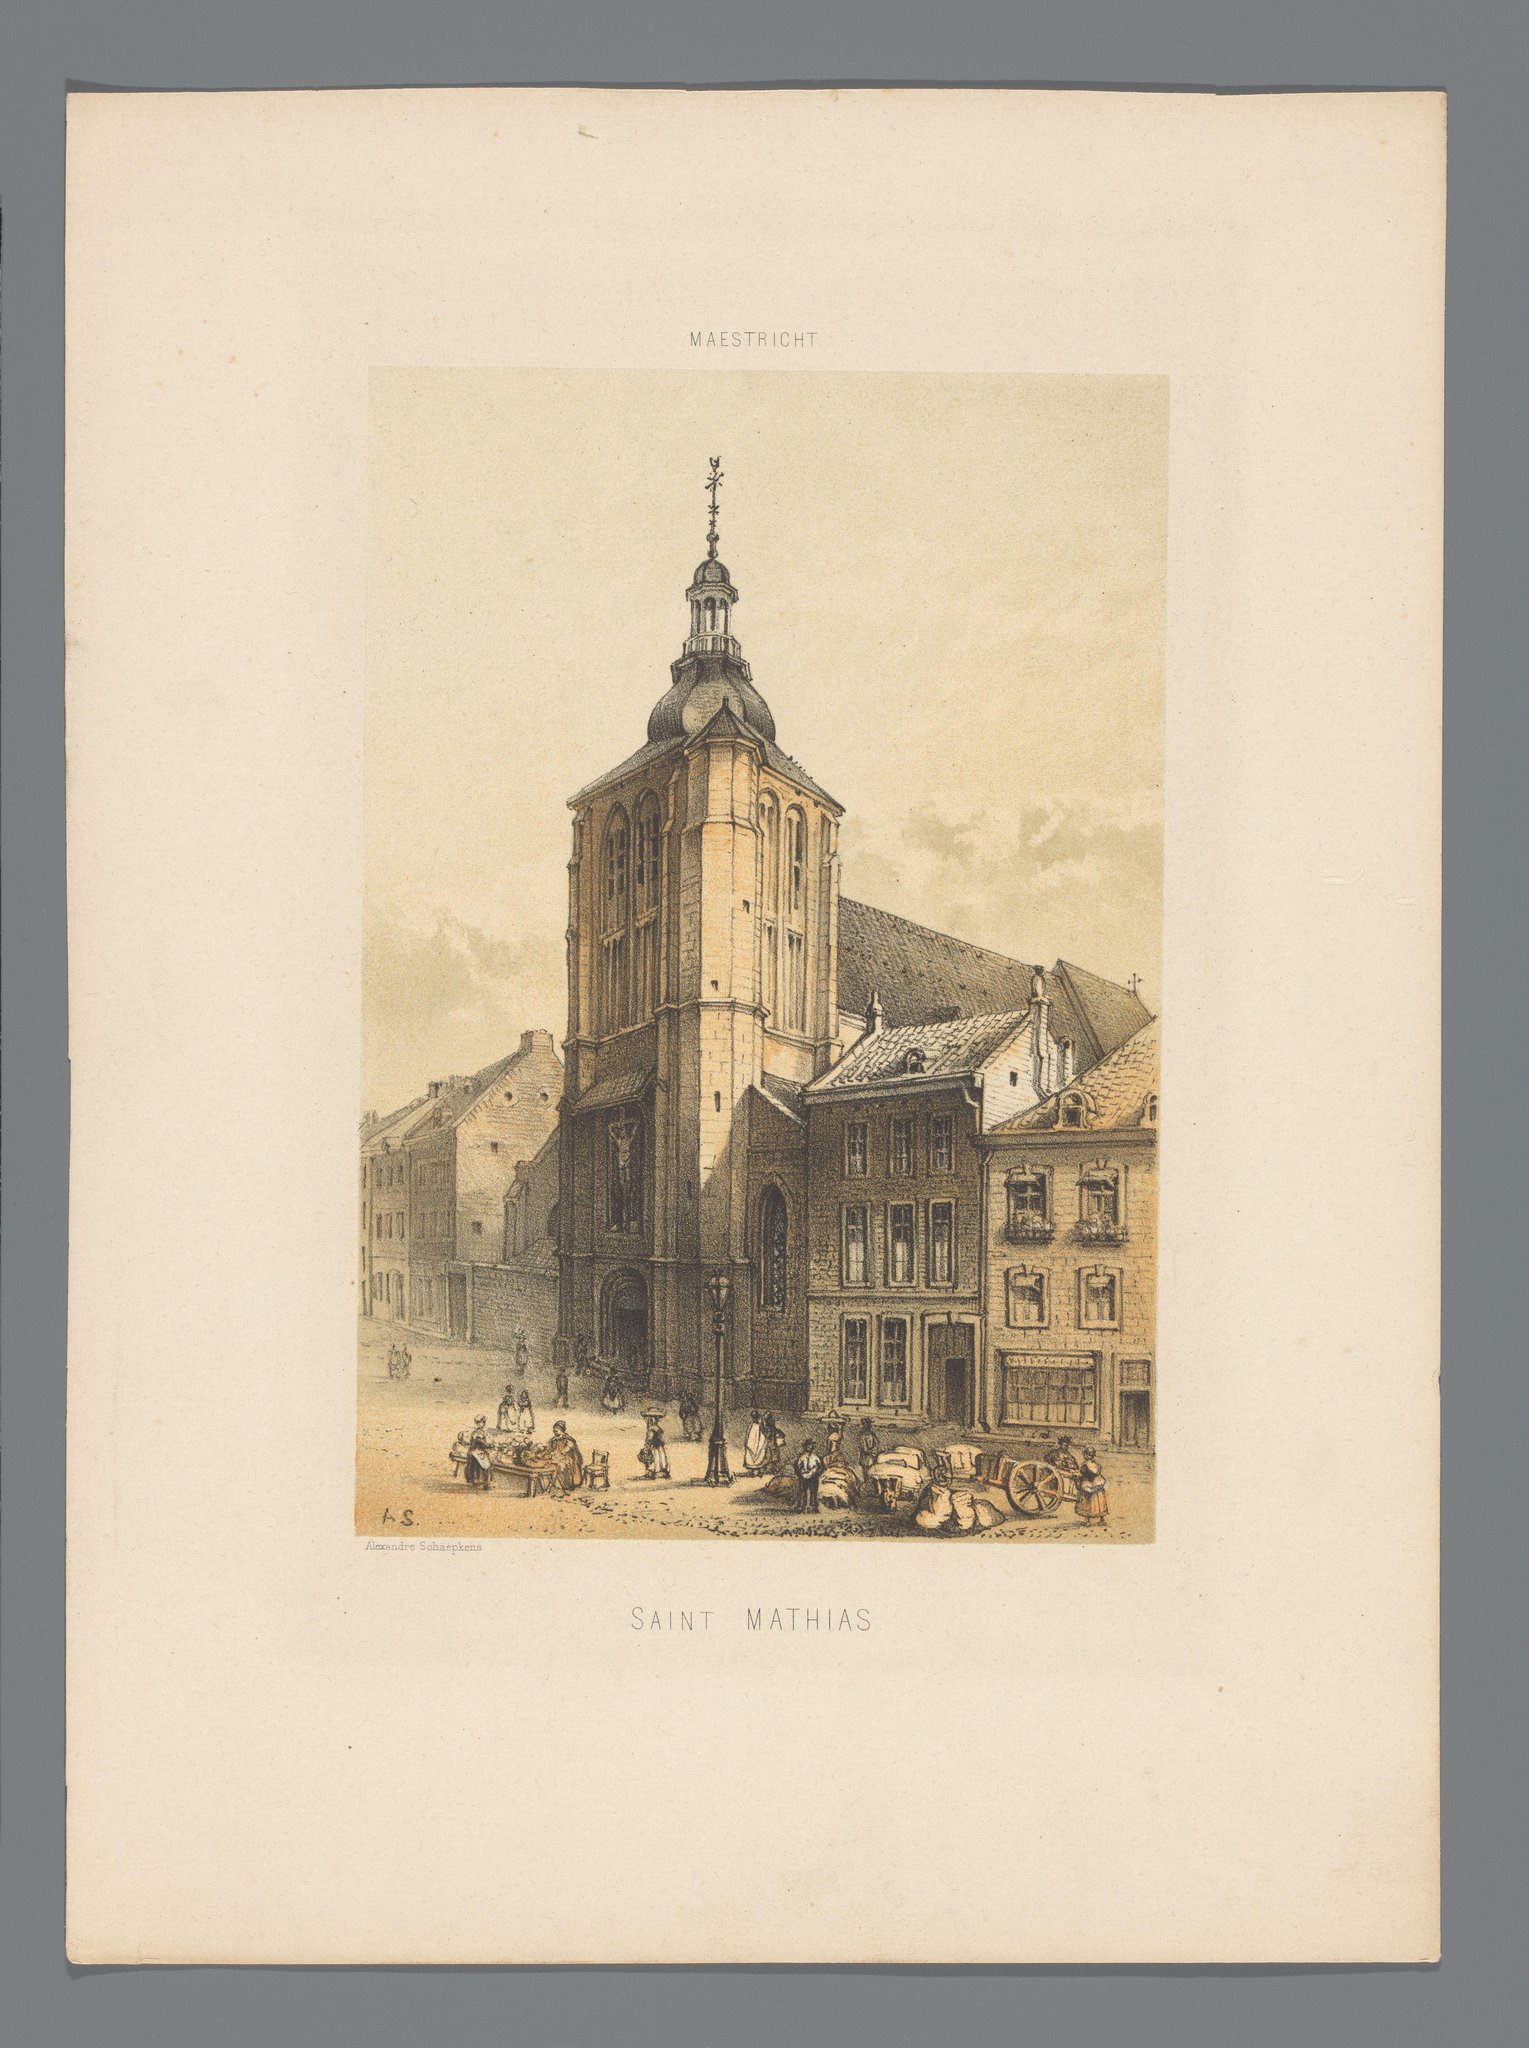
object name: print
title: Saint Mathias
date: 1857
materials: paper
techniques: tone lithography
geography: brussels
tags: church (exterior), maastricht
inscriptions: collector's mark: Lugt 2228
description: Mensen op de straat voor de Sint-Matthiaskerk. Onderdeel van een omslag met een serie van tien lithografieën van monumenten te Maastricht.